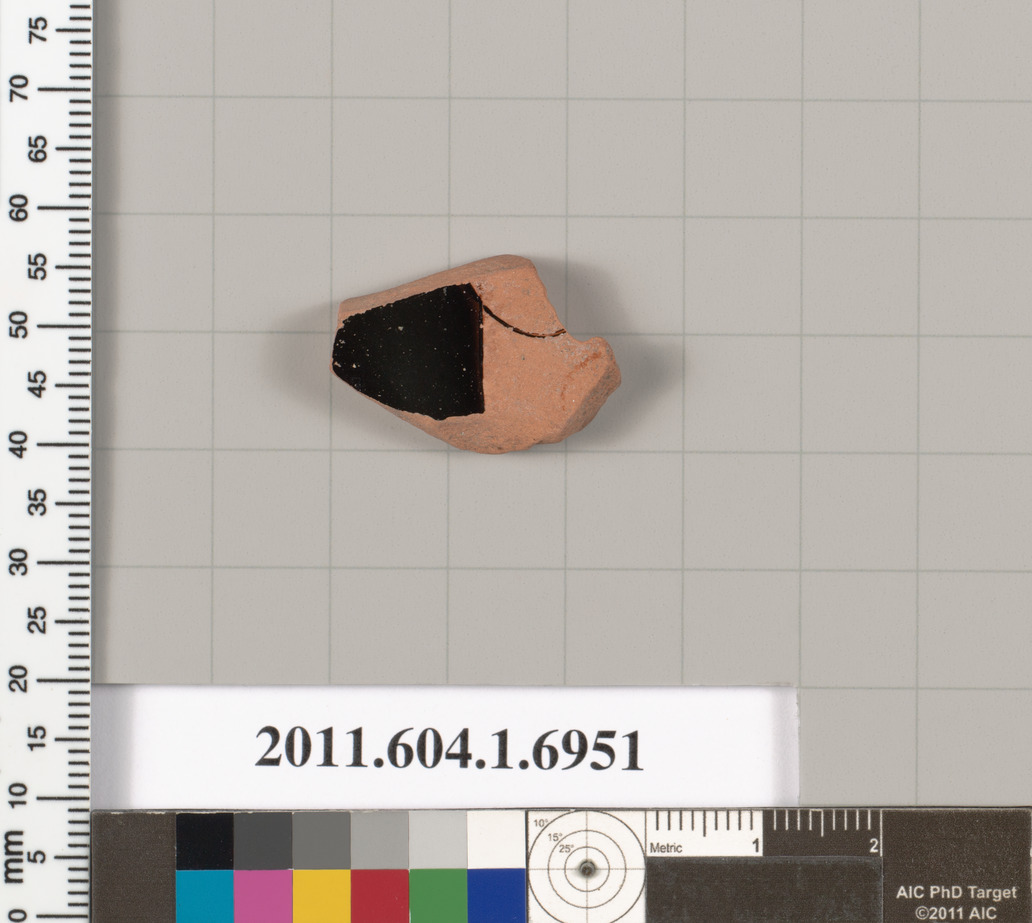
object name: kylix fragment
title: Terracotta fragment of a kylix (drinking cup)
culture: greek, attic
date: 490-470 BCE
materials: terracotta